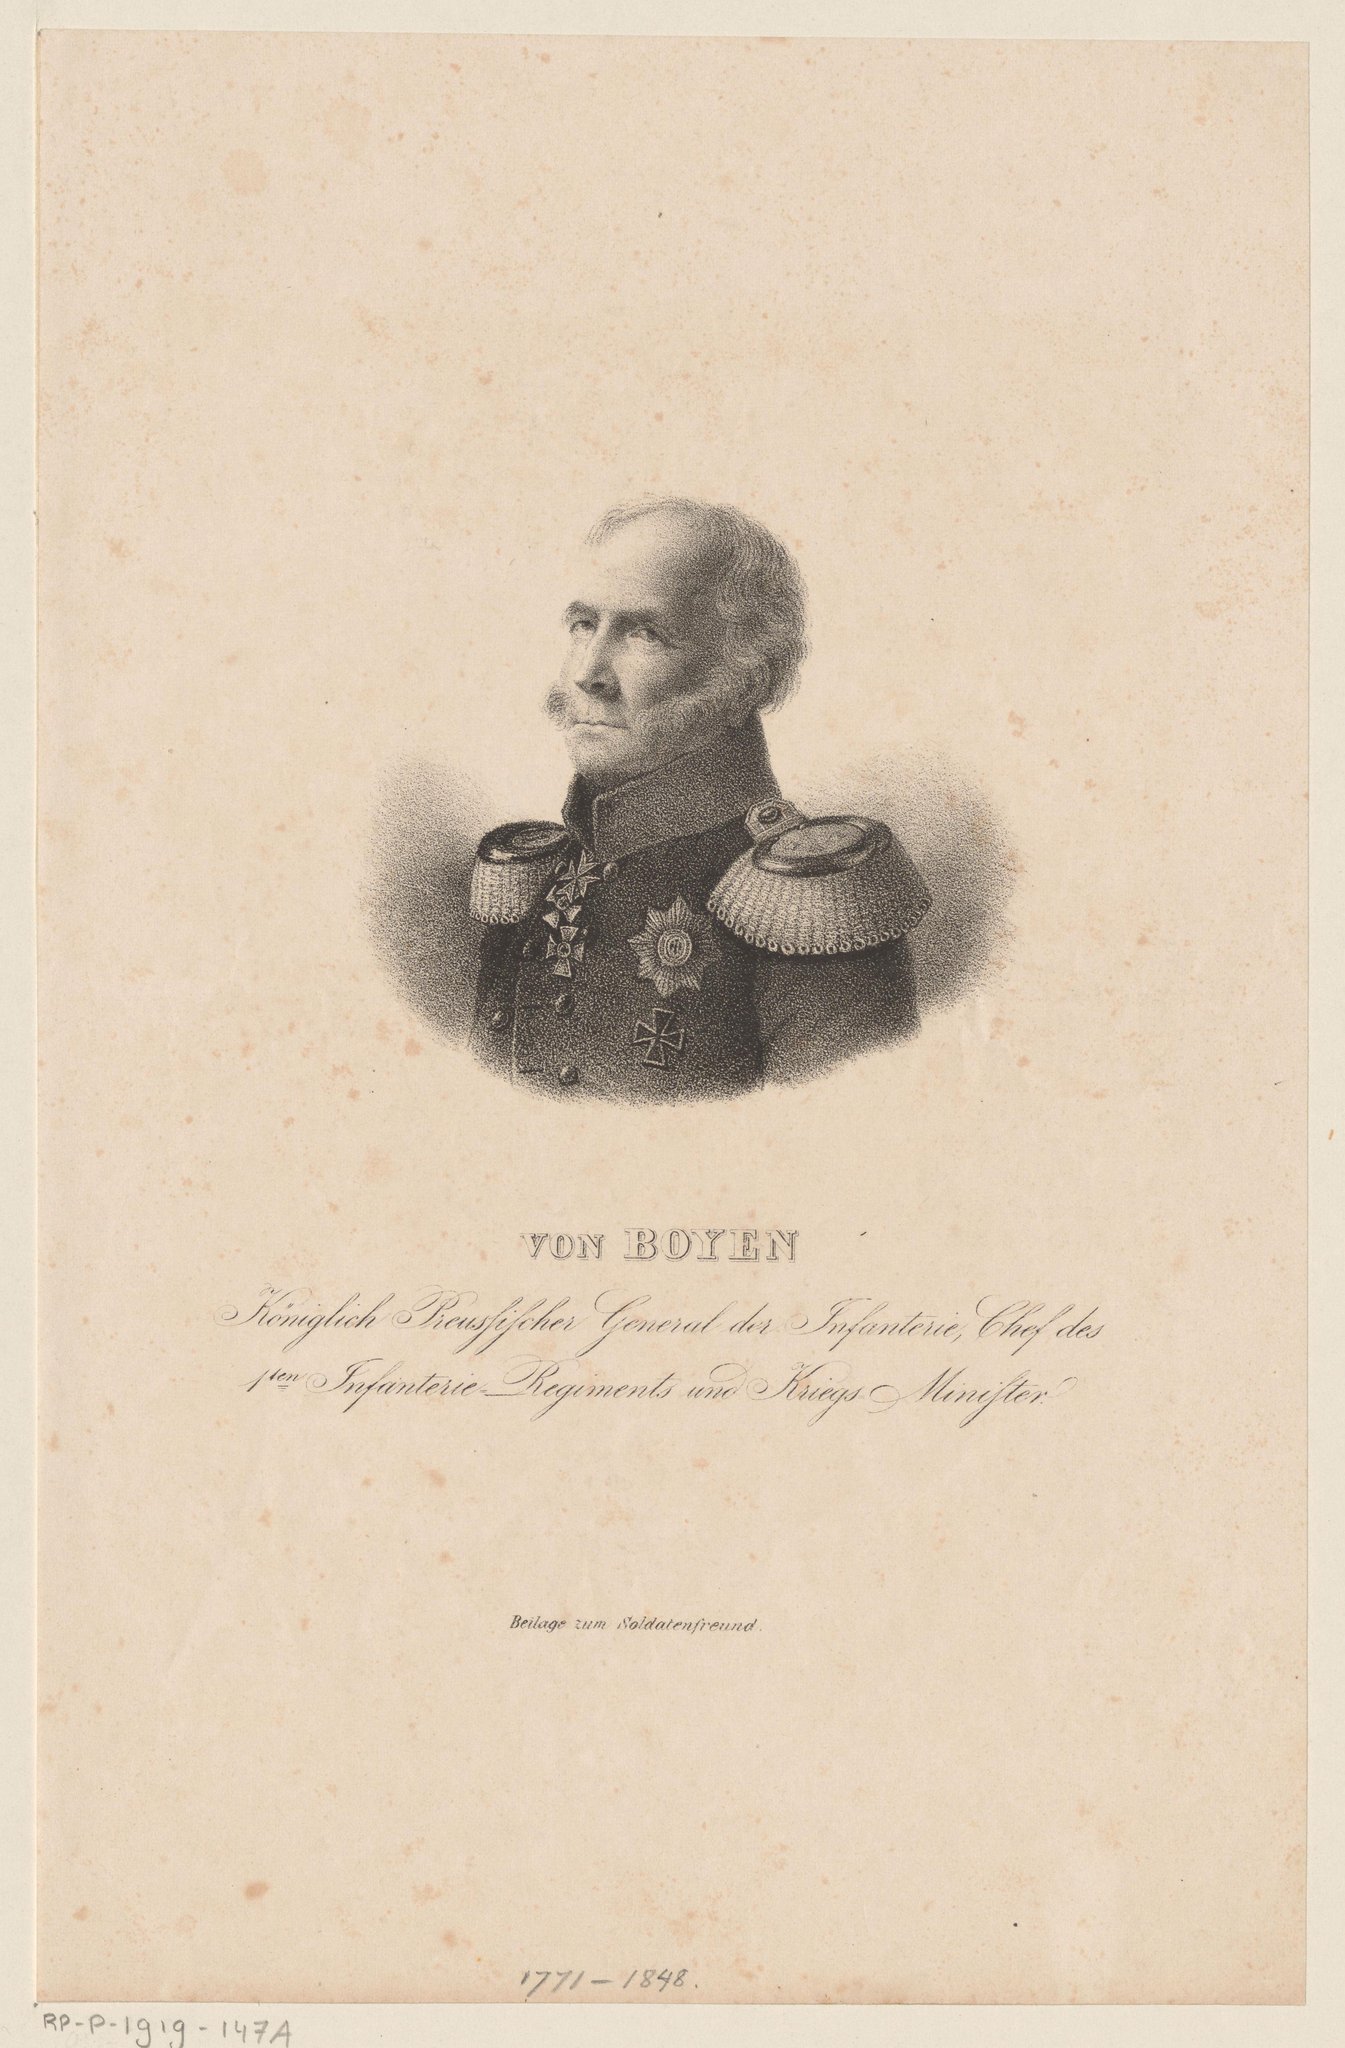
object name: print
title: Portret van Leopold Hermann Ludwig von Boyen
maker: Anonymous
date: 1814-1850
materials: paper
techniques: lithograph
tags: historical persons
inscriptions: collector's mark: Lugt 2228